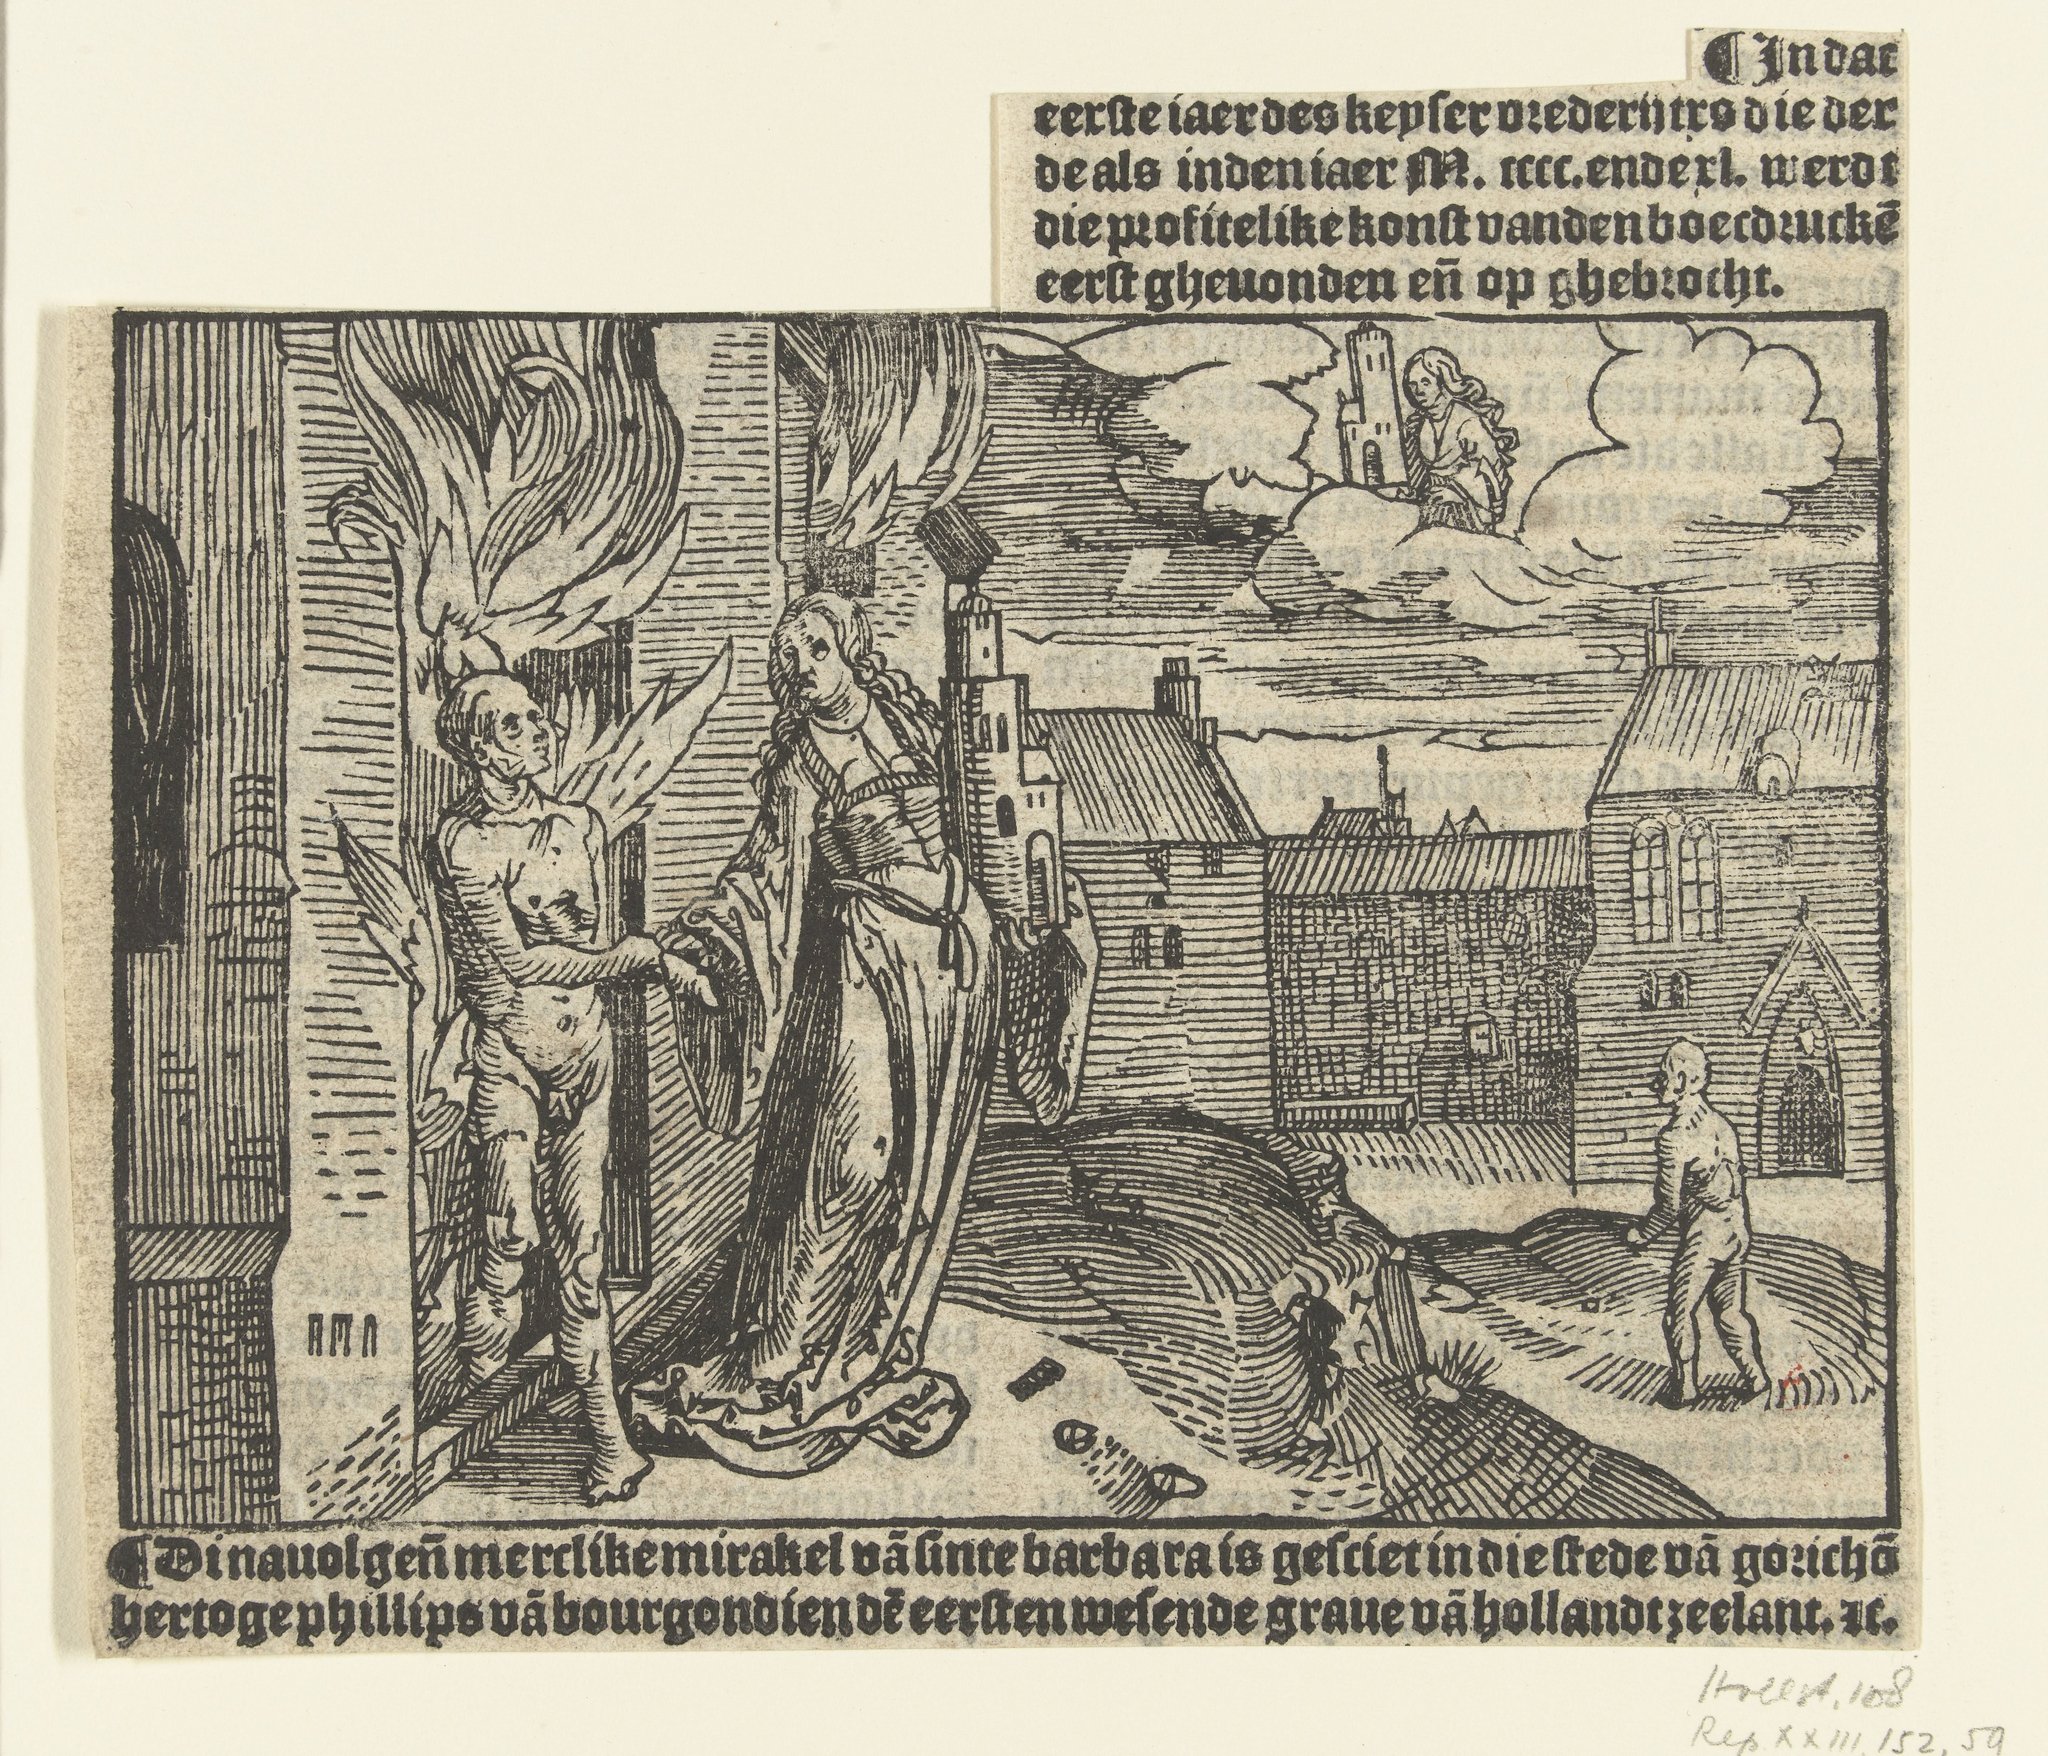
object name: book illustration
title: Het wonder van de heilige Barbara te Gorinchem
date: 1513-1517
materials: paper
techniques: woodcut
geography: leiden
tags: st. barbara as patroness of armourers and firearms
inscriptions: collector's mark: Lugt 240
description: Blad uit boek. Tekst boven en onder afbeelding. Het wonder van de heilige Barbara te Gorinchem in het jaar 1448. Barbara met toren in haar arm, redt een man uit een brandend huis. Aan hemel in de wolken opnieuw Barbara met de toren.